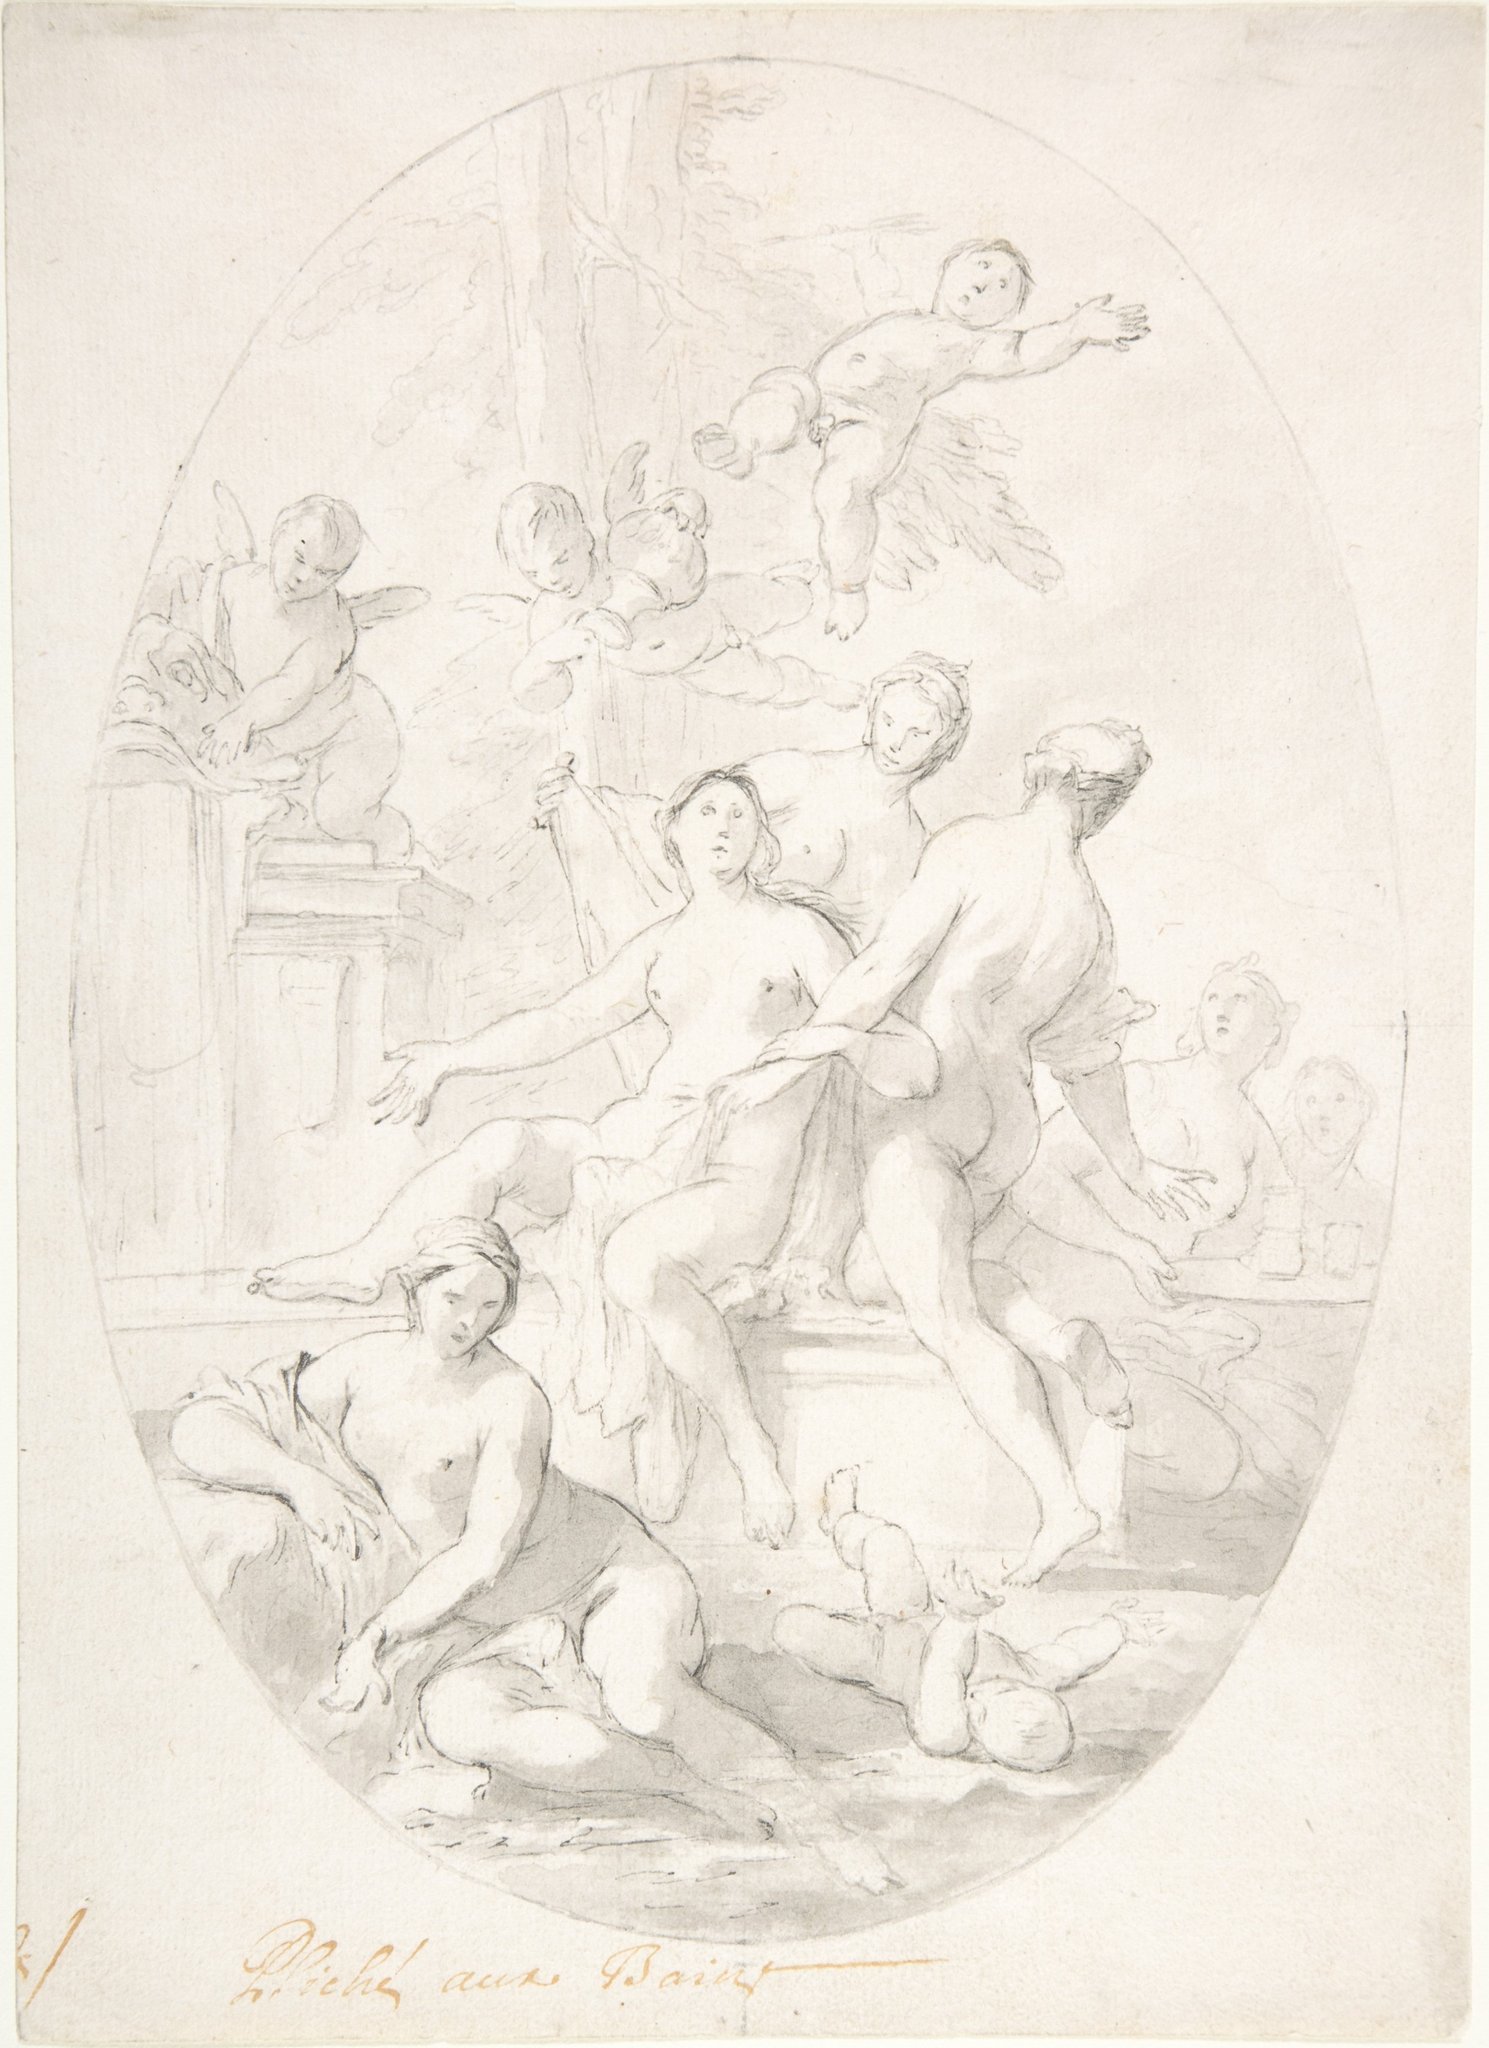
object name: drawing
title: The Bath of Psyche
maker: pierre jacques cazes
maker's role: artist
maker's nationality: french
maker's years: 1676-1754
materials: chalk, ink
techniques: pen, wash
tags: female nudes,psyche,bathing